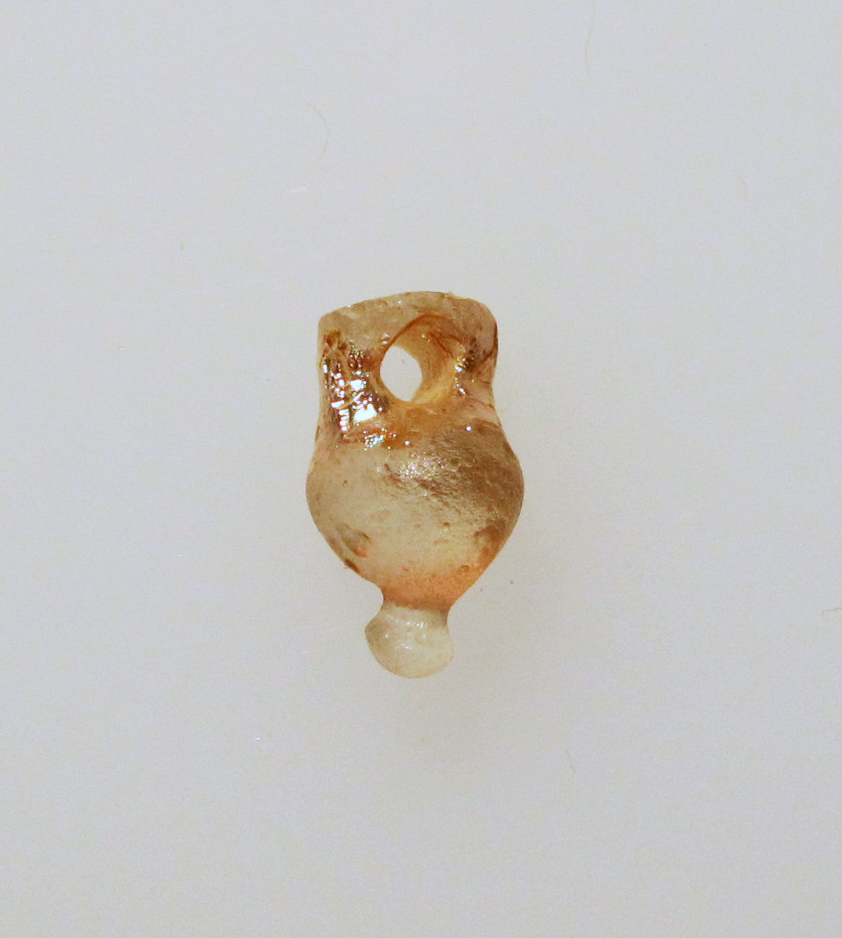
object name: pendant in the form of an amphora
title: Glass pendant in the form of an amphora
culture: celtic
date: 300-201 BCE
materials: glass